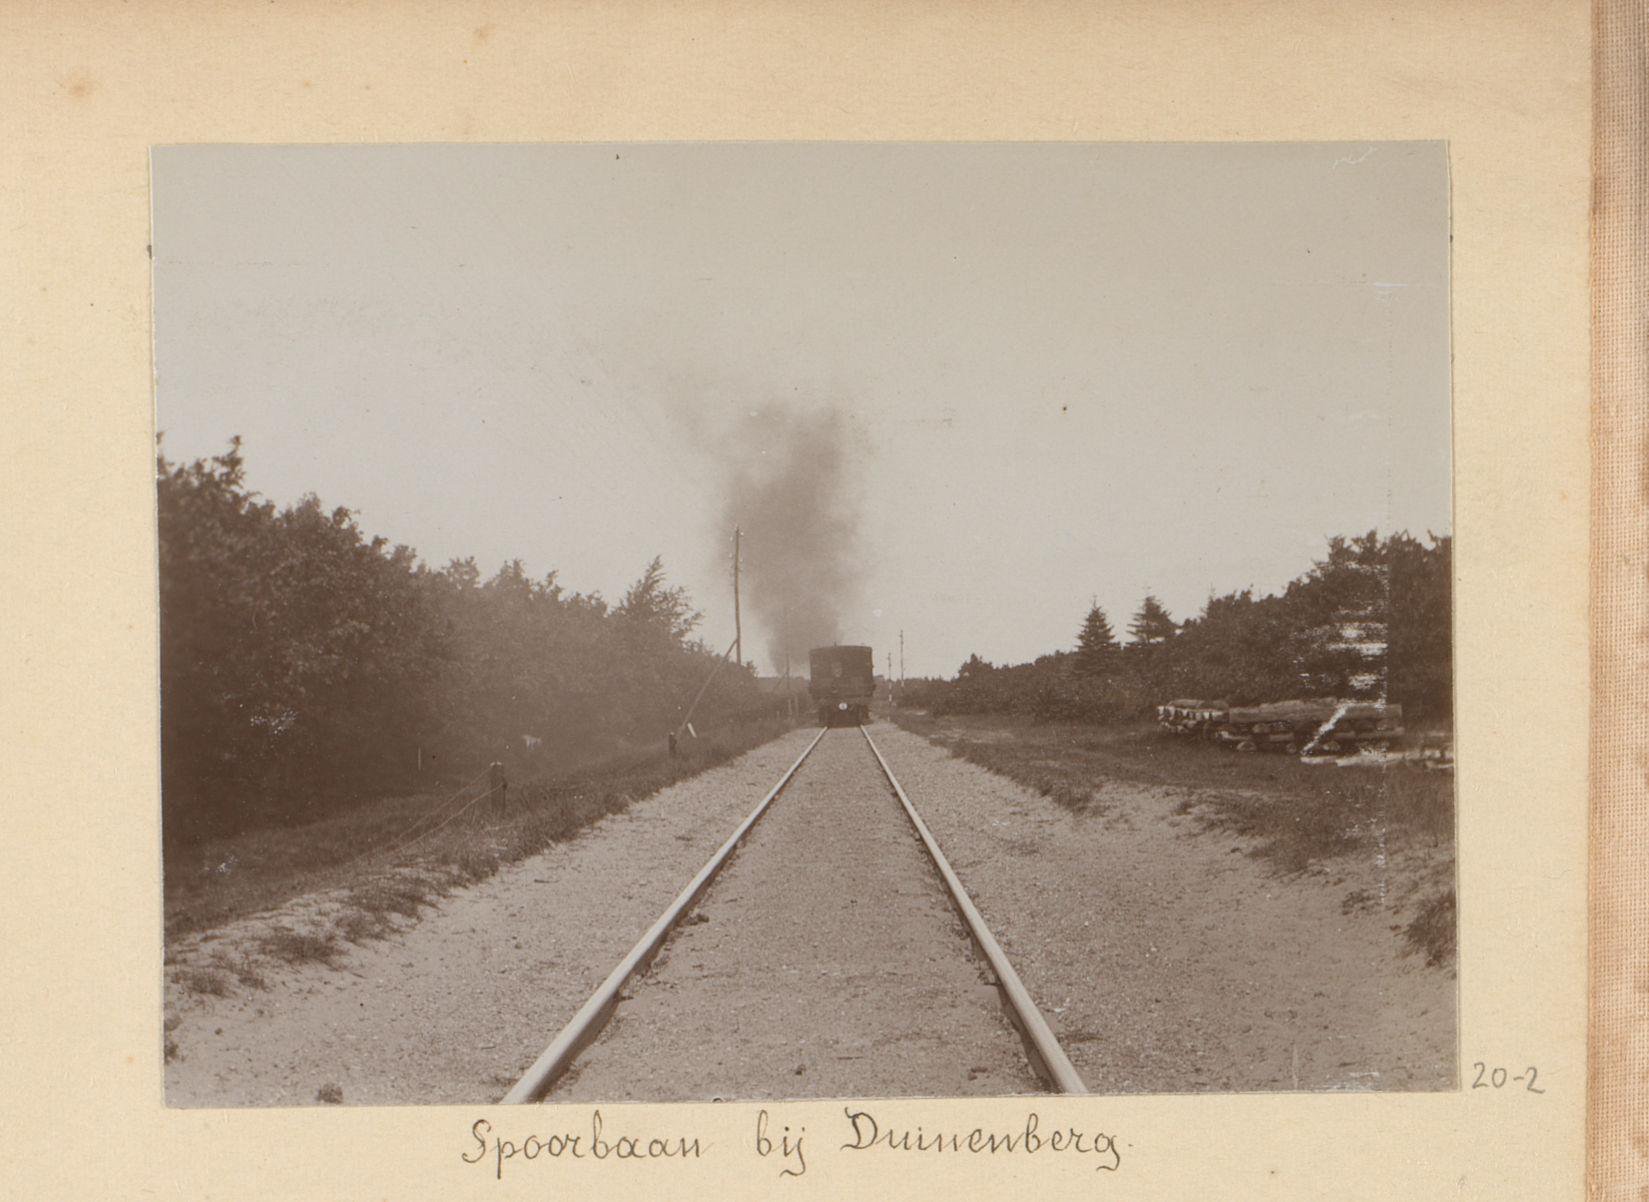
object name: album leaf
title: Spoorbaan bij Duinenberg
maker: hendrik herman van den berg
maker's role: amateurfotograaf, jurist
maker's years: 1875-1944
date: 1890-1894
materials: paper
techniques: collodion silver print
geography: velsen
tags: railway, train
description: Foto 2 op albumblad 20 uit album "Amsterdam 1890-1894".